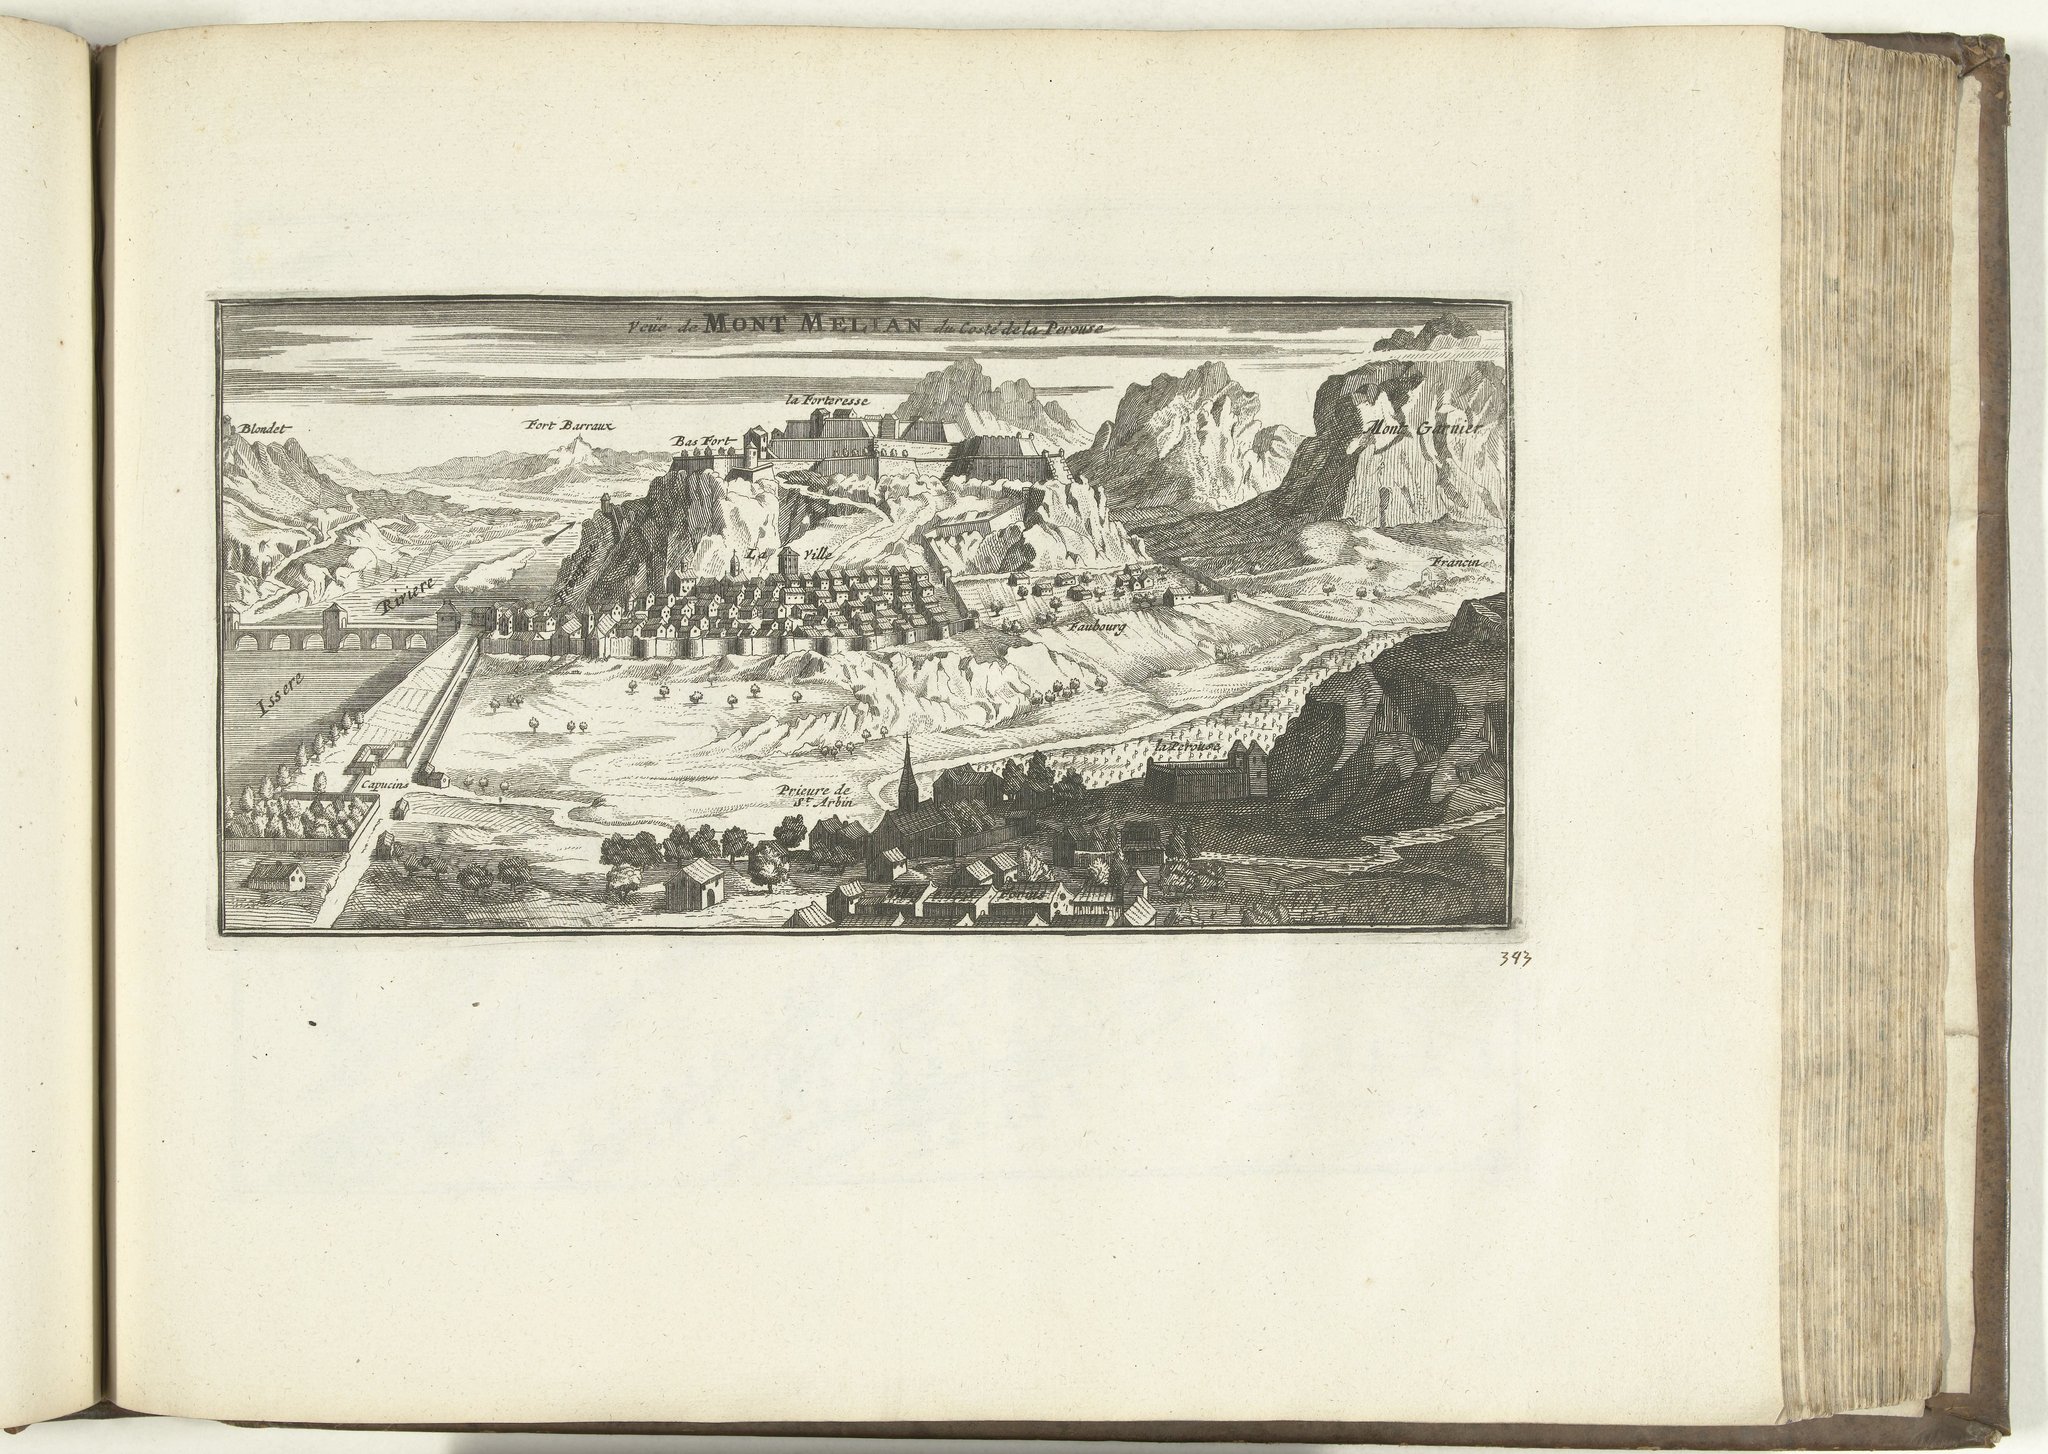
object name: print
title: Les Forces de l'Europe, Asie, Afrique et Amerique (...) Comme aussi les Cartes des Côtes de France et d'Espagne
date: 1726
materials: paper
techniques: etching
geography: leiden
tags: fortress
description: Gezicht op de vesting van Montmélian. Plaat nr. 343 in deel XIV van het prentwerk: Les Forces de l'Europe, Asie, Afrique et Amerique ... Comme aussi les Cartes des Côtes de France et d'Espagne uit 1726, dit tweede deel met 271 met de hand genummerde platen van vermaarde sterke steden en vestingen in het kader van de Spaanse Successieoorlog 1701-1713. Voor het merendeel zijn deze platen gekopieerd naar de anonieme Franse platen van vermaarde sterke steden en vestingen: in Les forces de l'Europe en in: Le theatre de la guerre, dans les Pays-Bas, beide oorspronkelijk uitgegeven door Nicolas de Fer te Parijs (1693-1697) in het kader van de Negenjarige Oorlog. Titel en opschriften in het Frans.